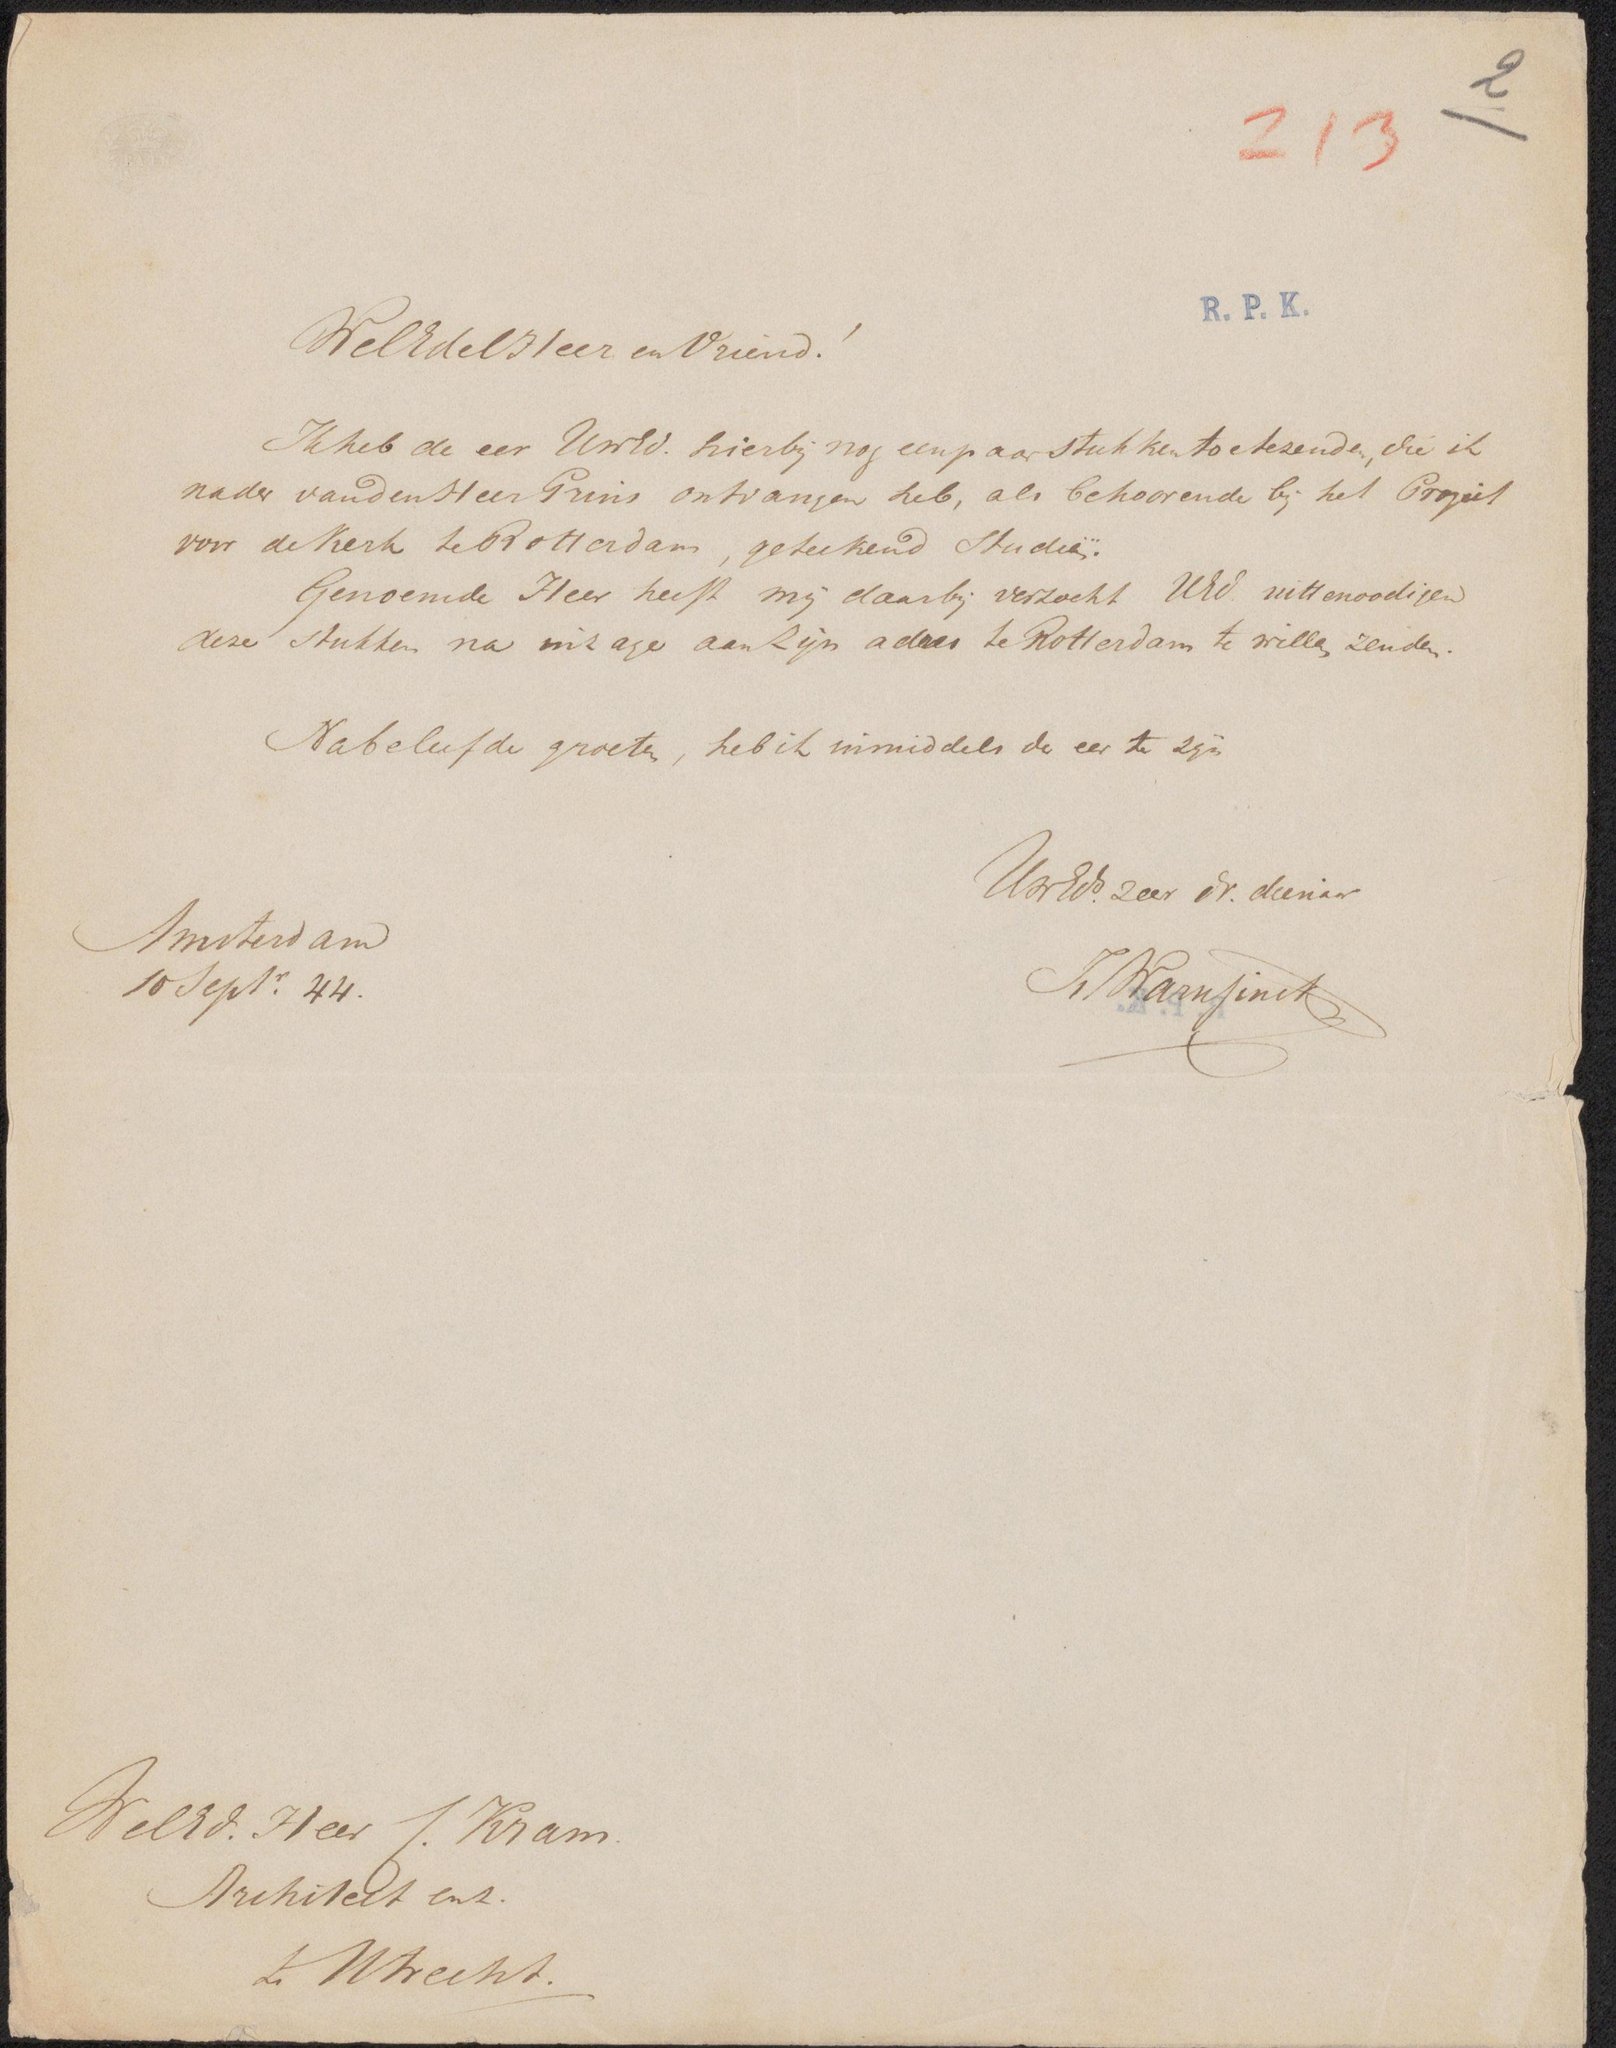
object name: letter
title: Brief aan Christiaan Kramm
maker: isaac warnsinck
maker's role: architect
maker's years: 1811-1857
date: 1844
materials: ink, paper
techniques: pen, writing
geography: amsterdam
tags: utrecht, print maker, draughtsman, christiaan kramm, drawing, architecture, rotterdam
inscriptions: collector's mark: Lugt 2233